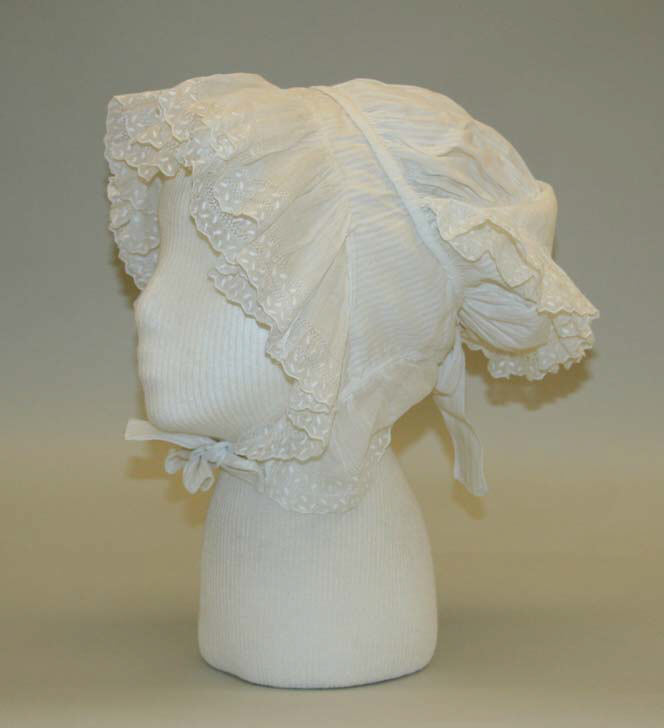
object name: cap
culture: american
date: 1801-1833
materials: cotton